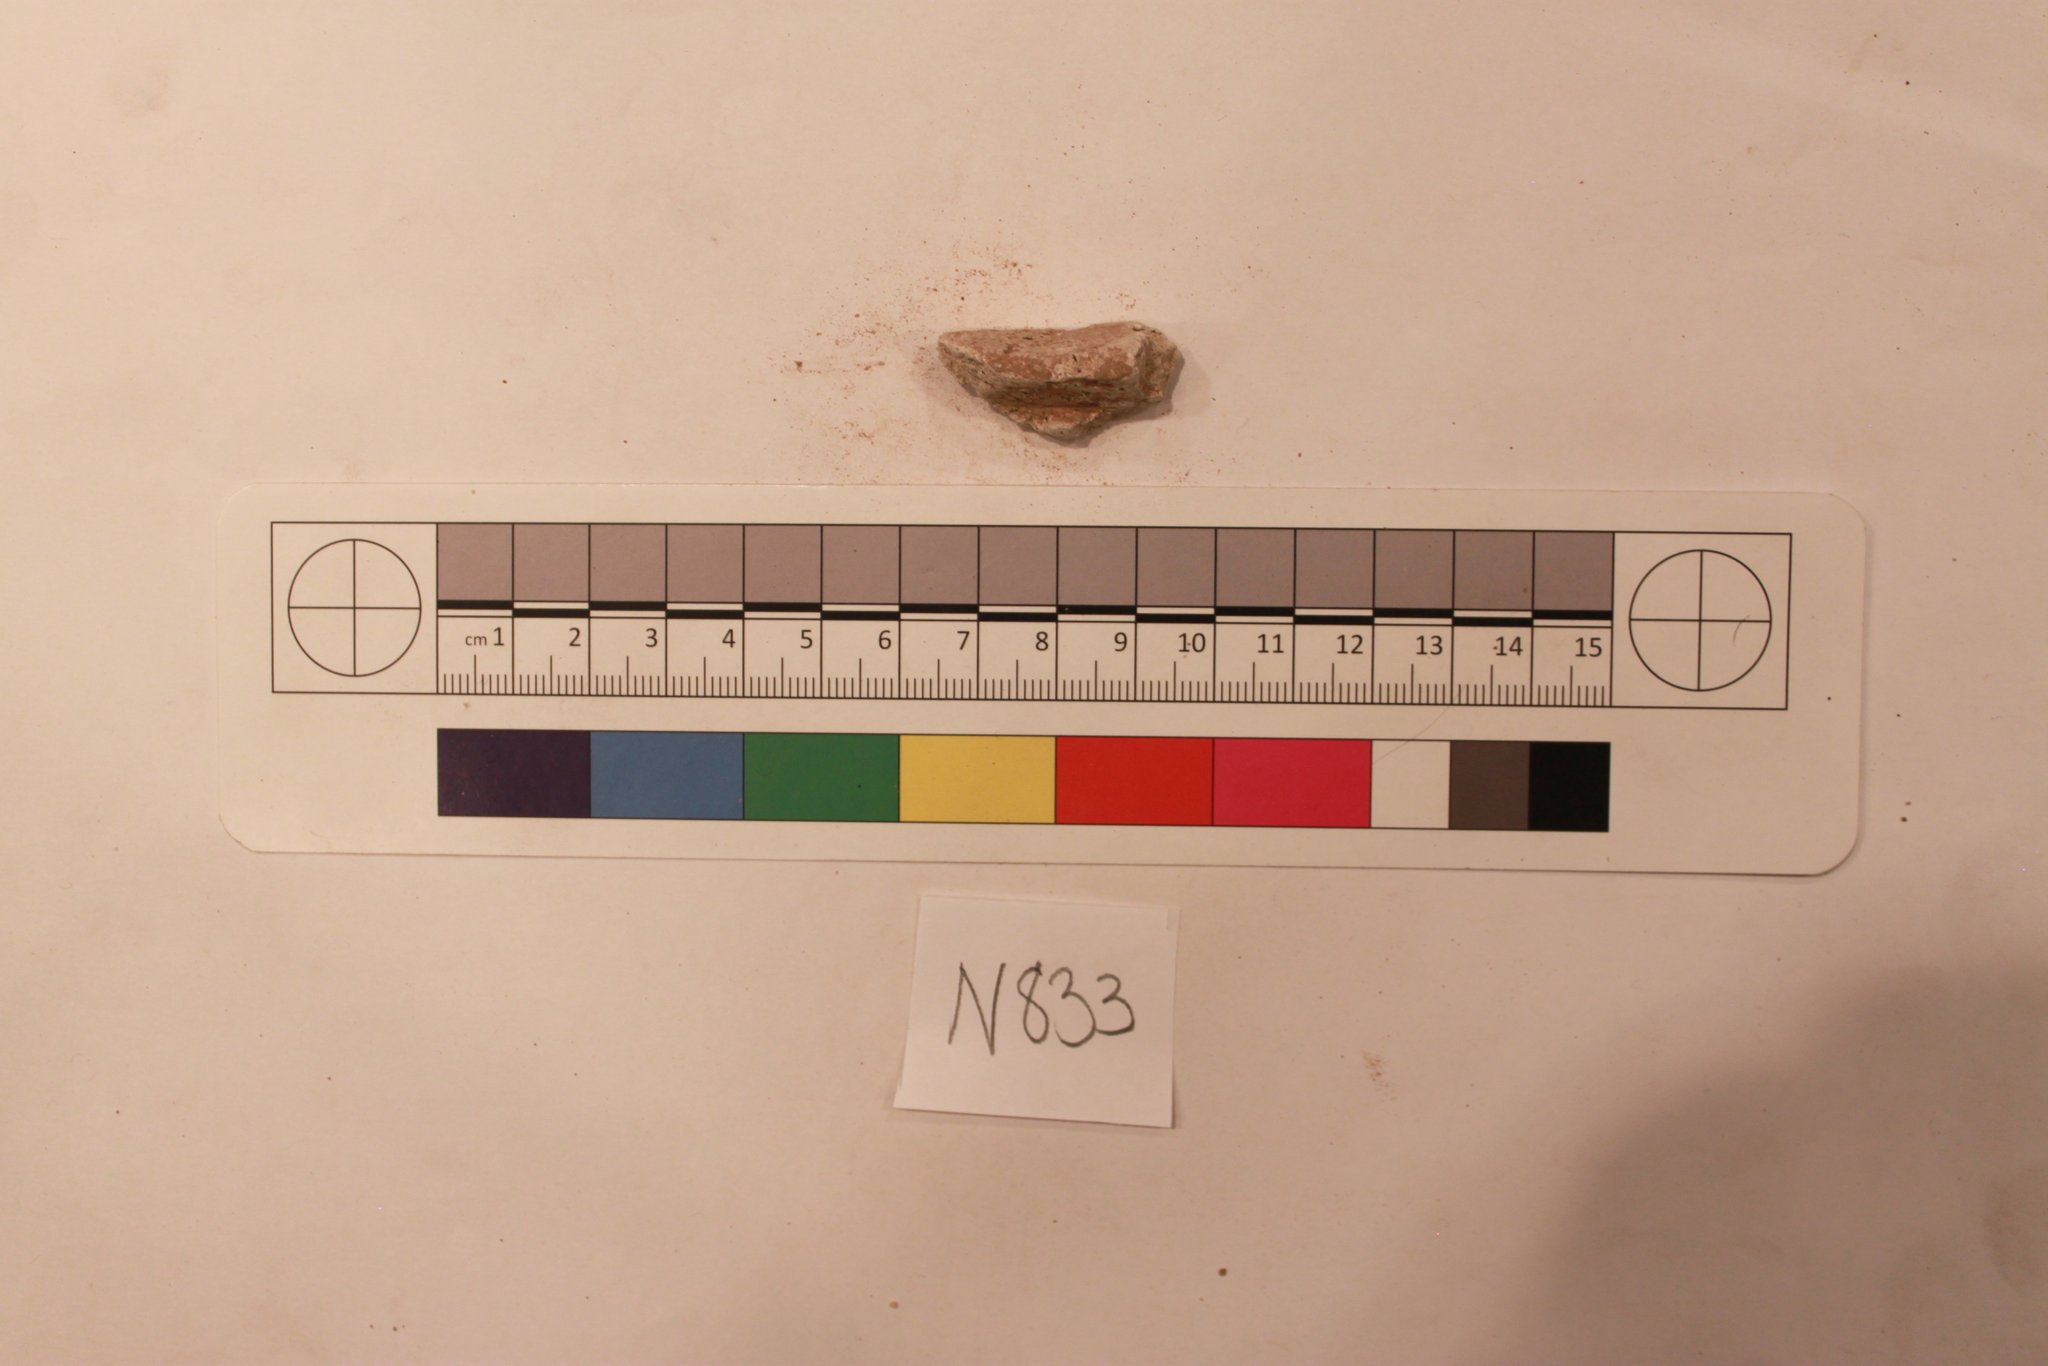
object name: fragment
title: Stucco Fragment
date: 701-1200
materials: plaster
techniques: carving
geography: iran